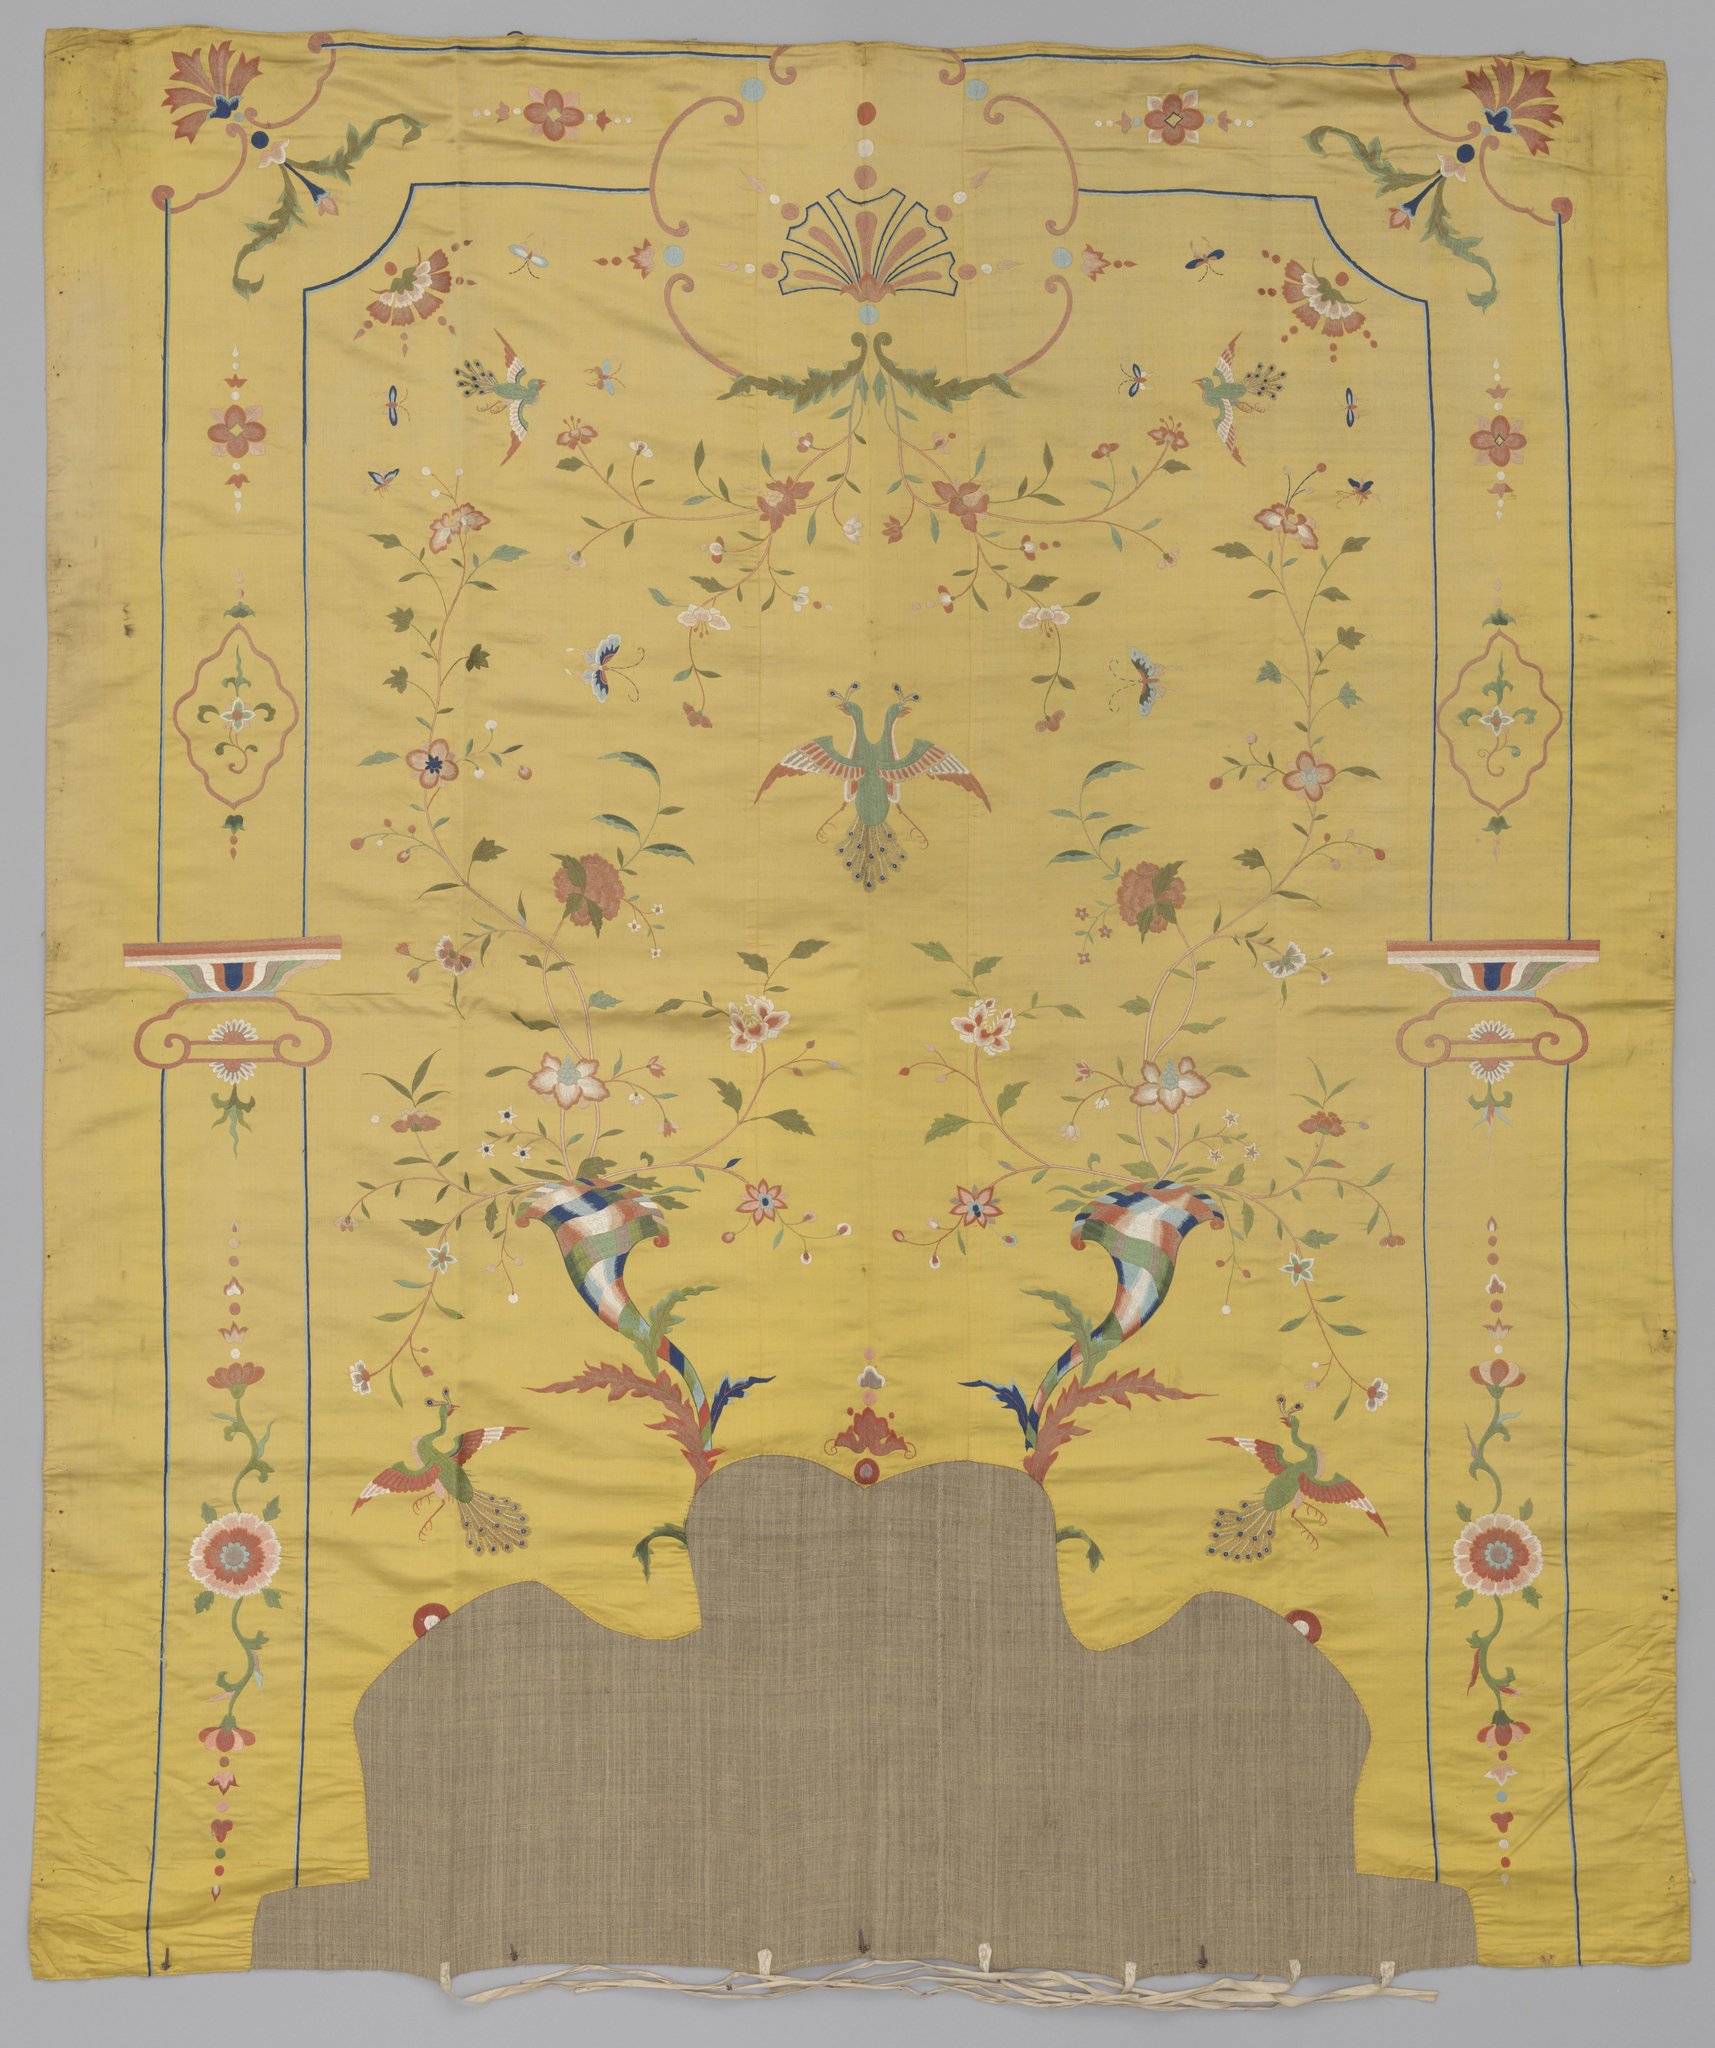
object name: silk textile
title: Geel zijden achterwand van een bedgarnituur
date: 1720-1740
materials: linen, silk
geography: guangdong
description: Geel zijden achterwand van een bedgarnituur geborduurd met dubbelkoppige pauw, bloemen, vlinders, hoorns van overvloed in veelkleurige zijde, gevoerd met grof linnen.